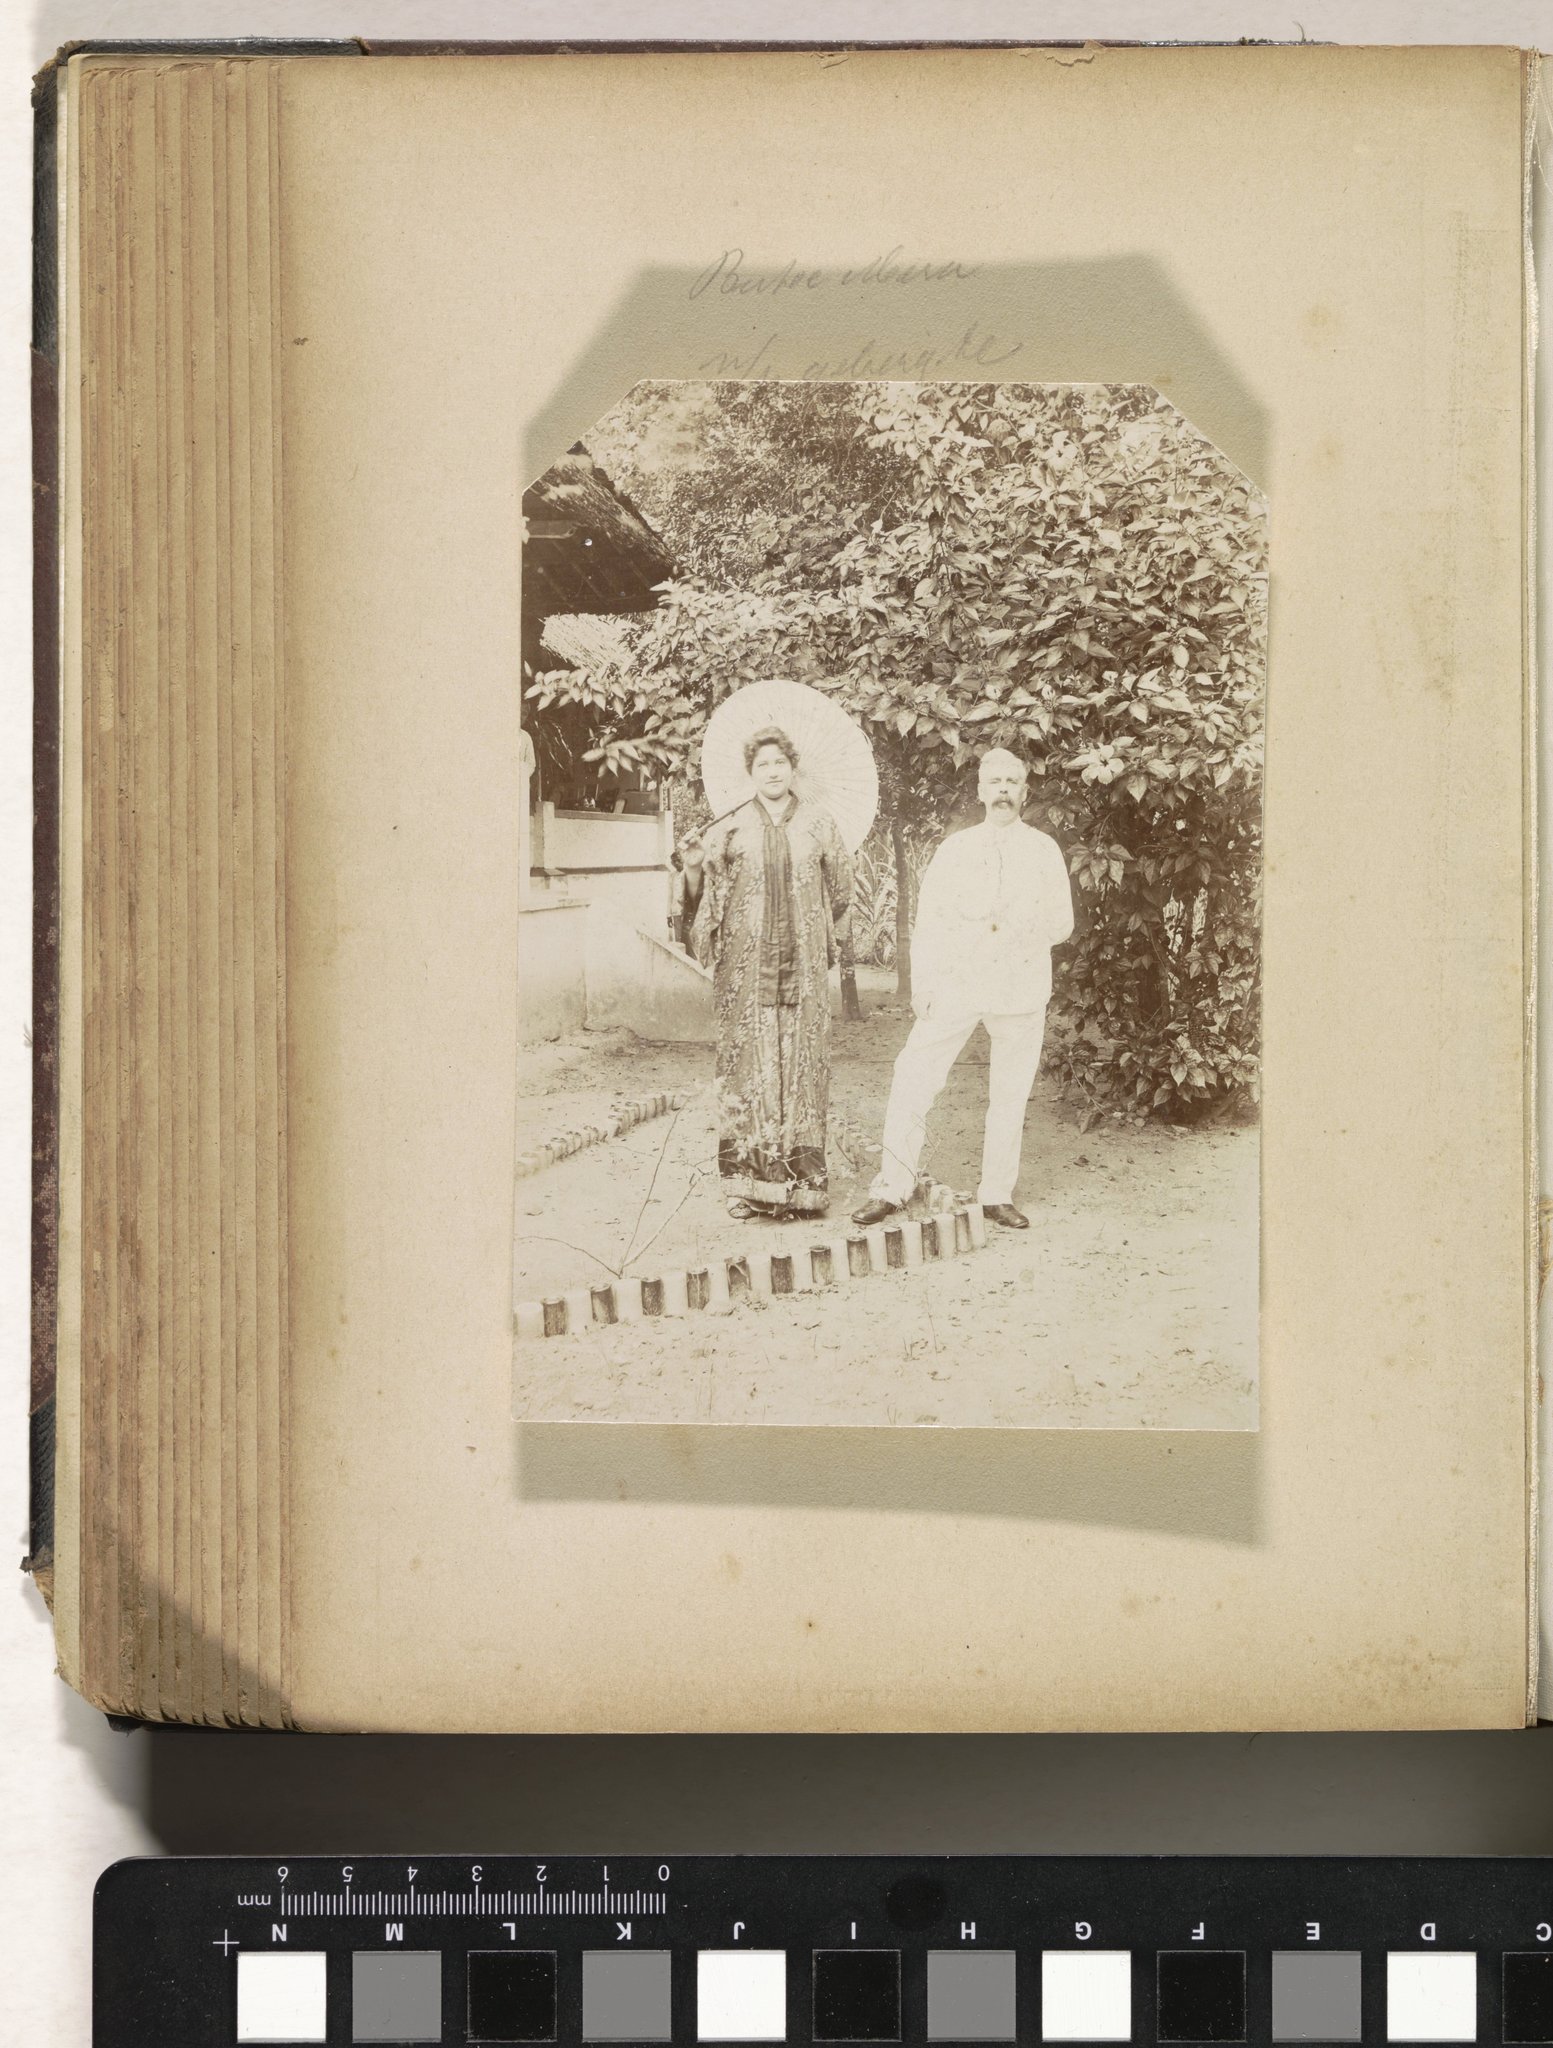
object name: photograph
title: Portret van een Europees echtpaar, vrouw met parasol in Indonesische dracht, man in licht kostuum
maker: Anonymous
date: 1900-1920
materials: paper, photographic support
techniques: gelatin silver print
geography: ambon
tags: marriage, married couple, 'matrimonium', dutch east indies, the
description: Onderdeel van Reisalbum met foto's van Ambon.